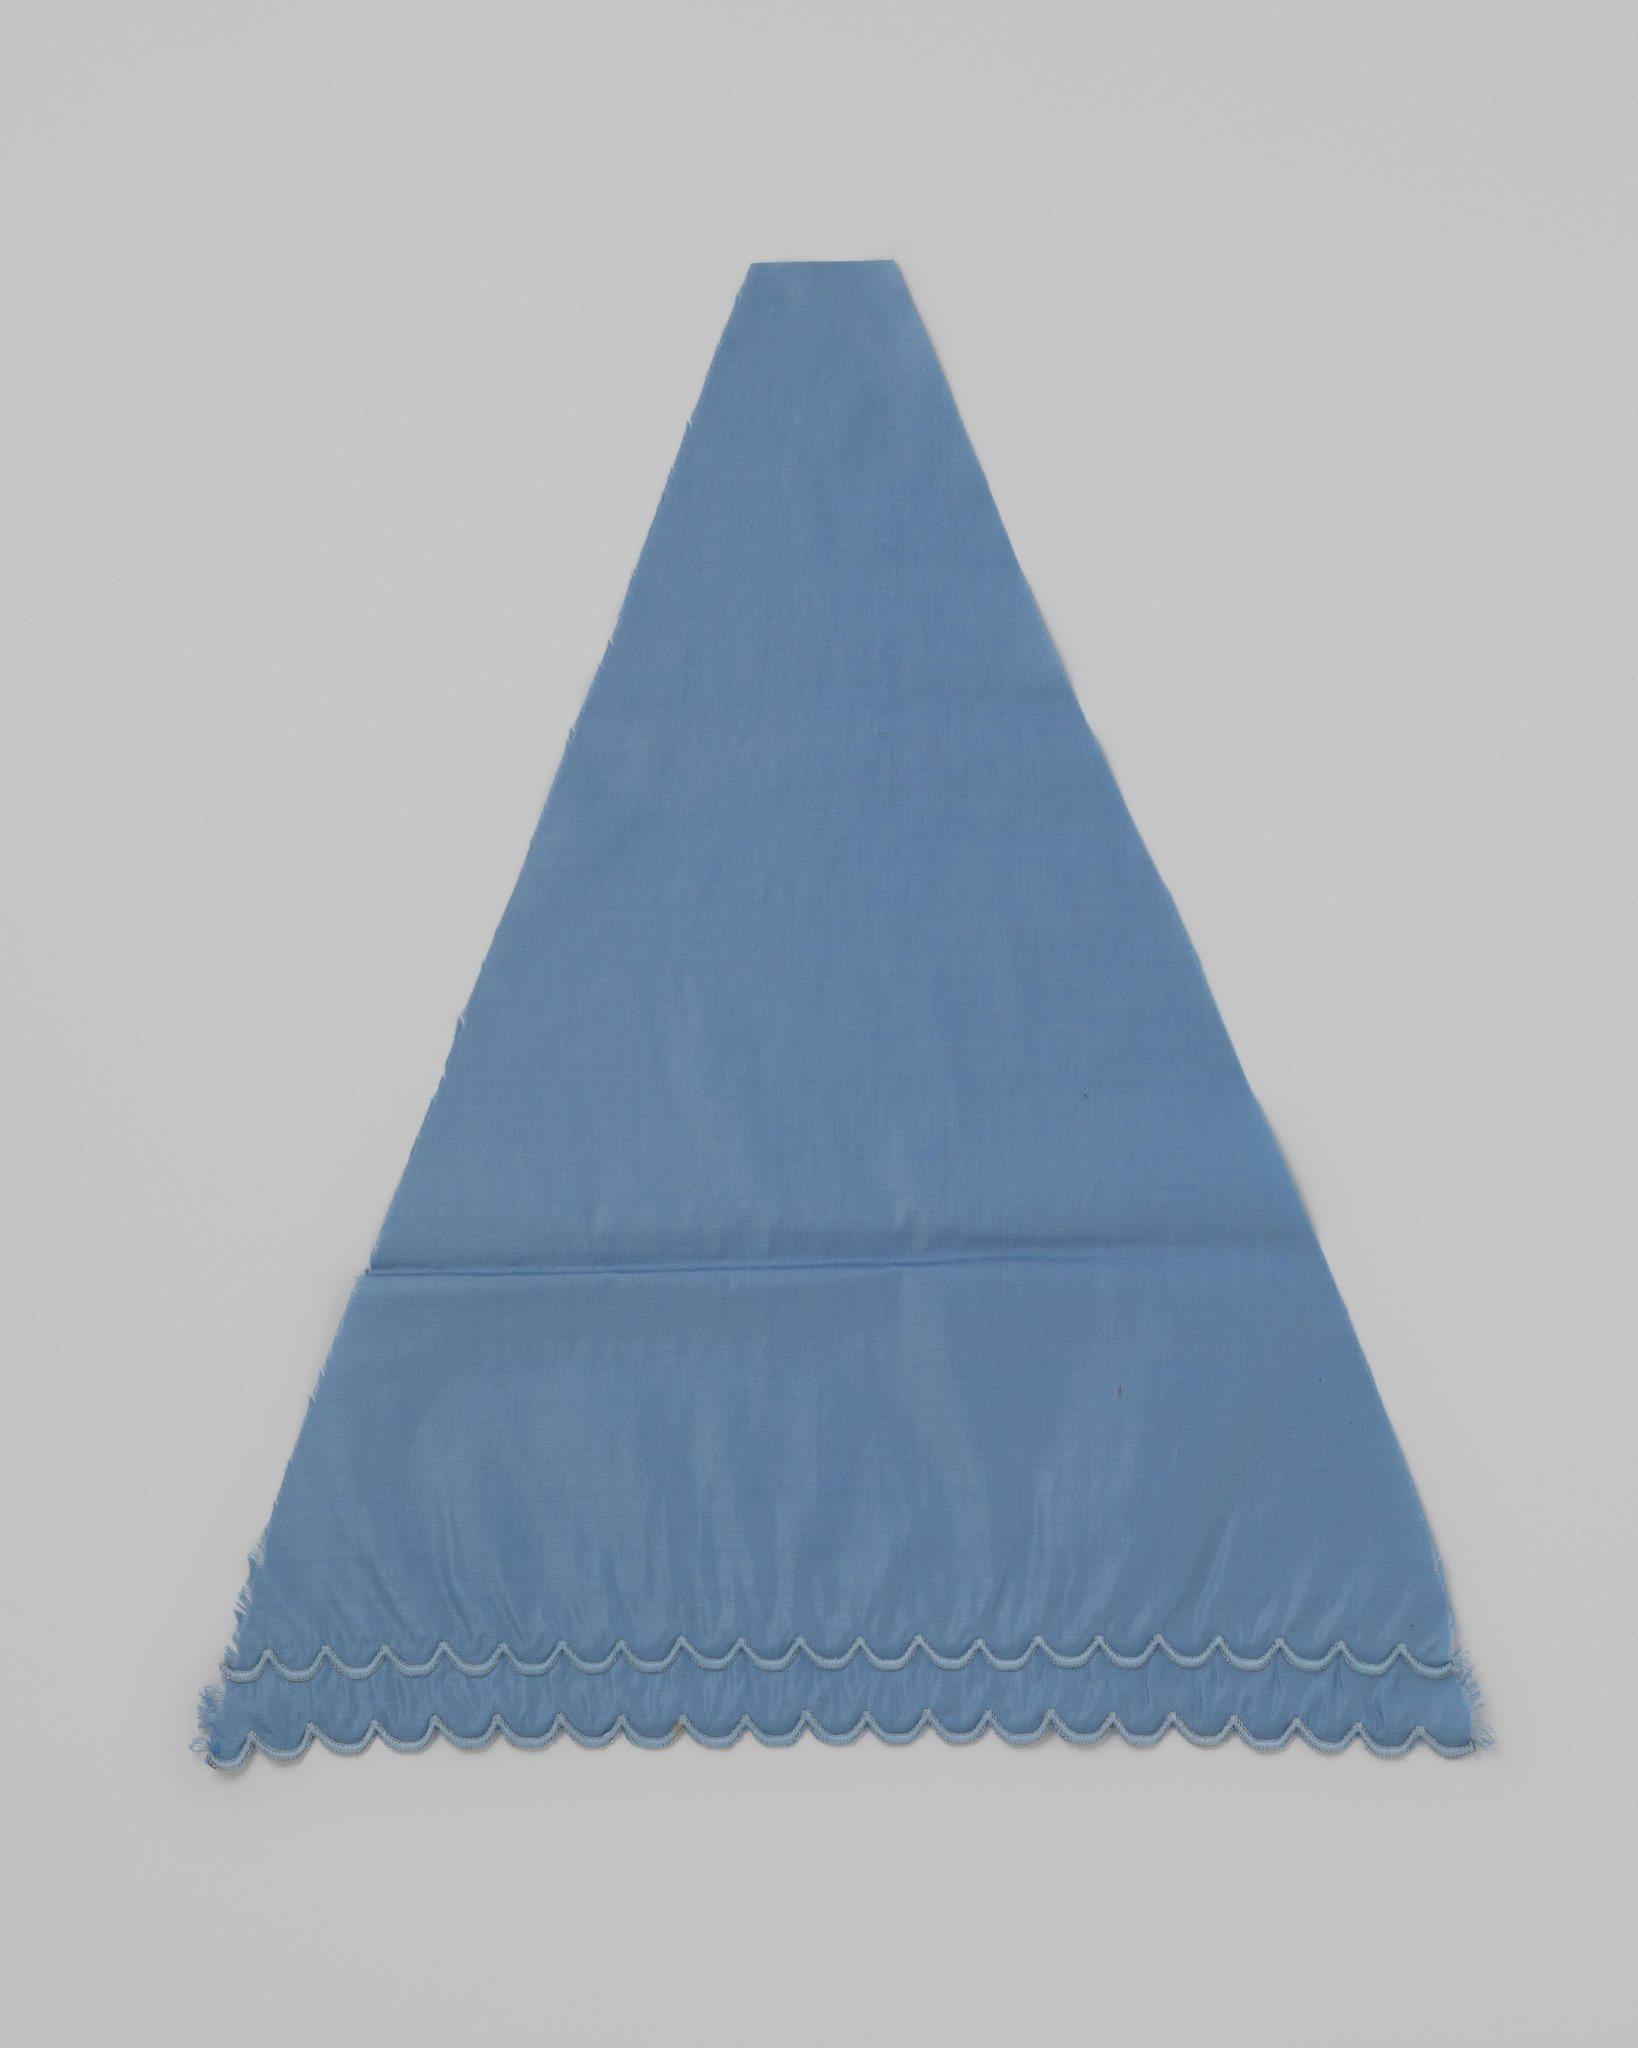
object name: parasoldek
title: Sector van een parasoldek van lichtblauw katoen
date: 1885-1900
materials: cotton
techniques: festoon stitch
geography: france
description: Sector van een parasoldek van lichtblauw katoen. Met een dubbele rij gefestonneerde schulpen.